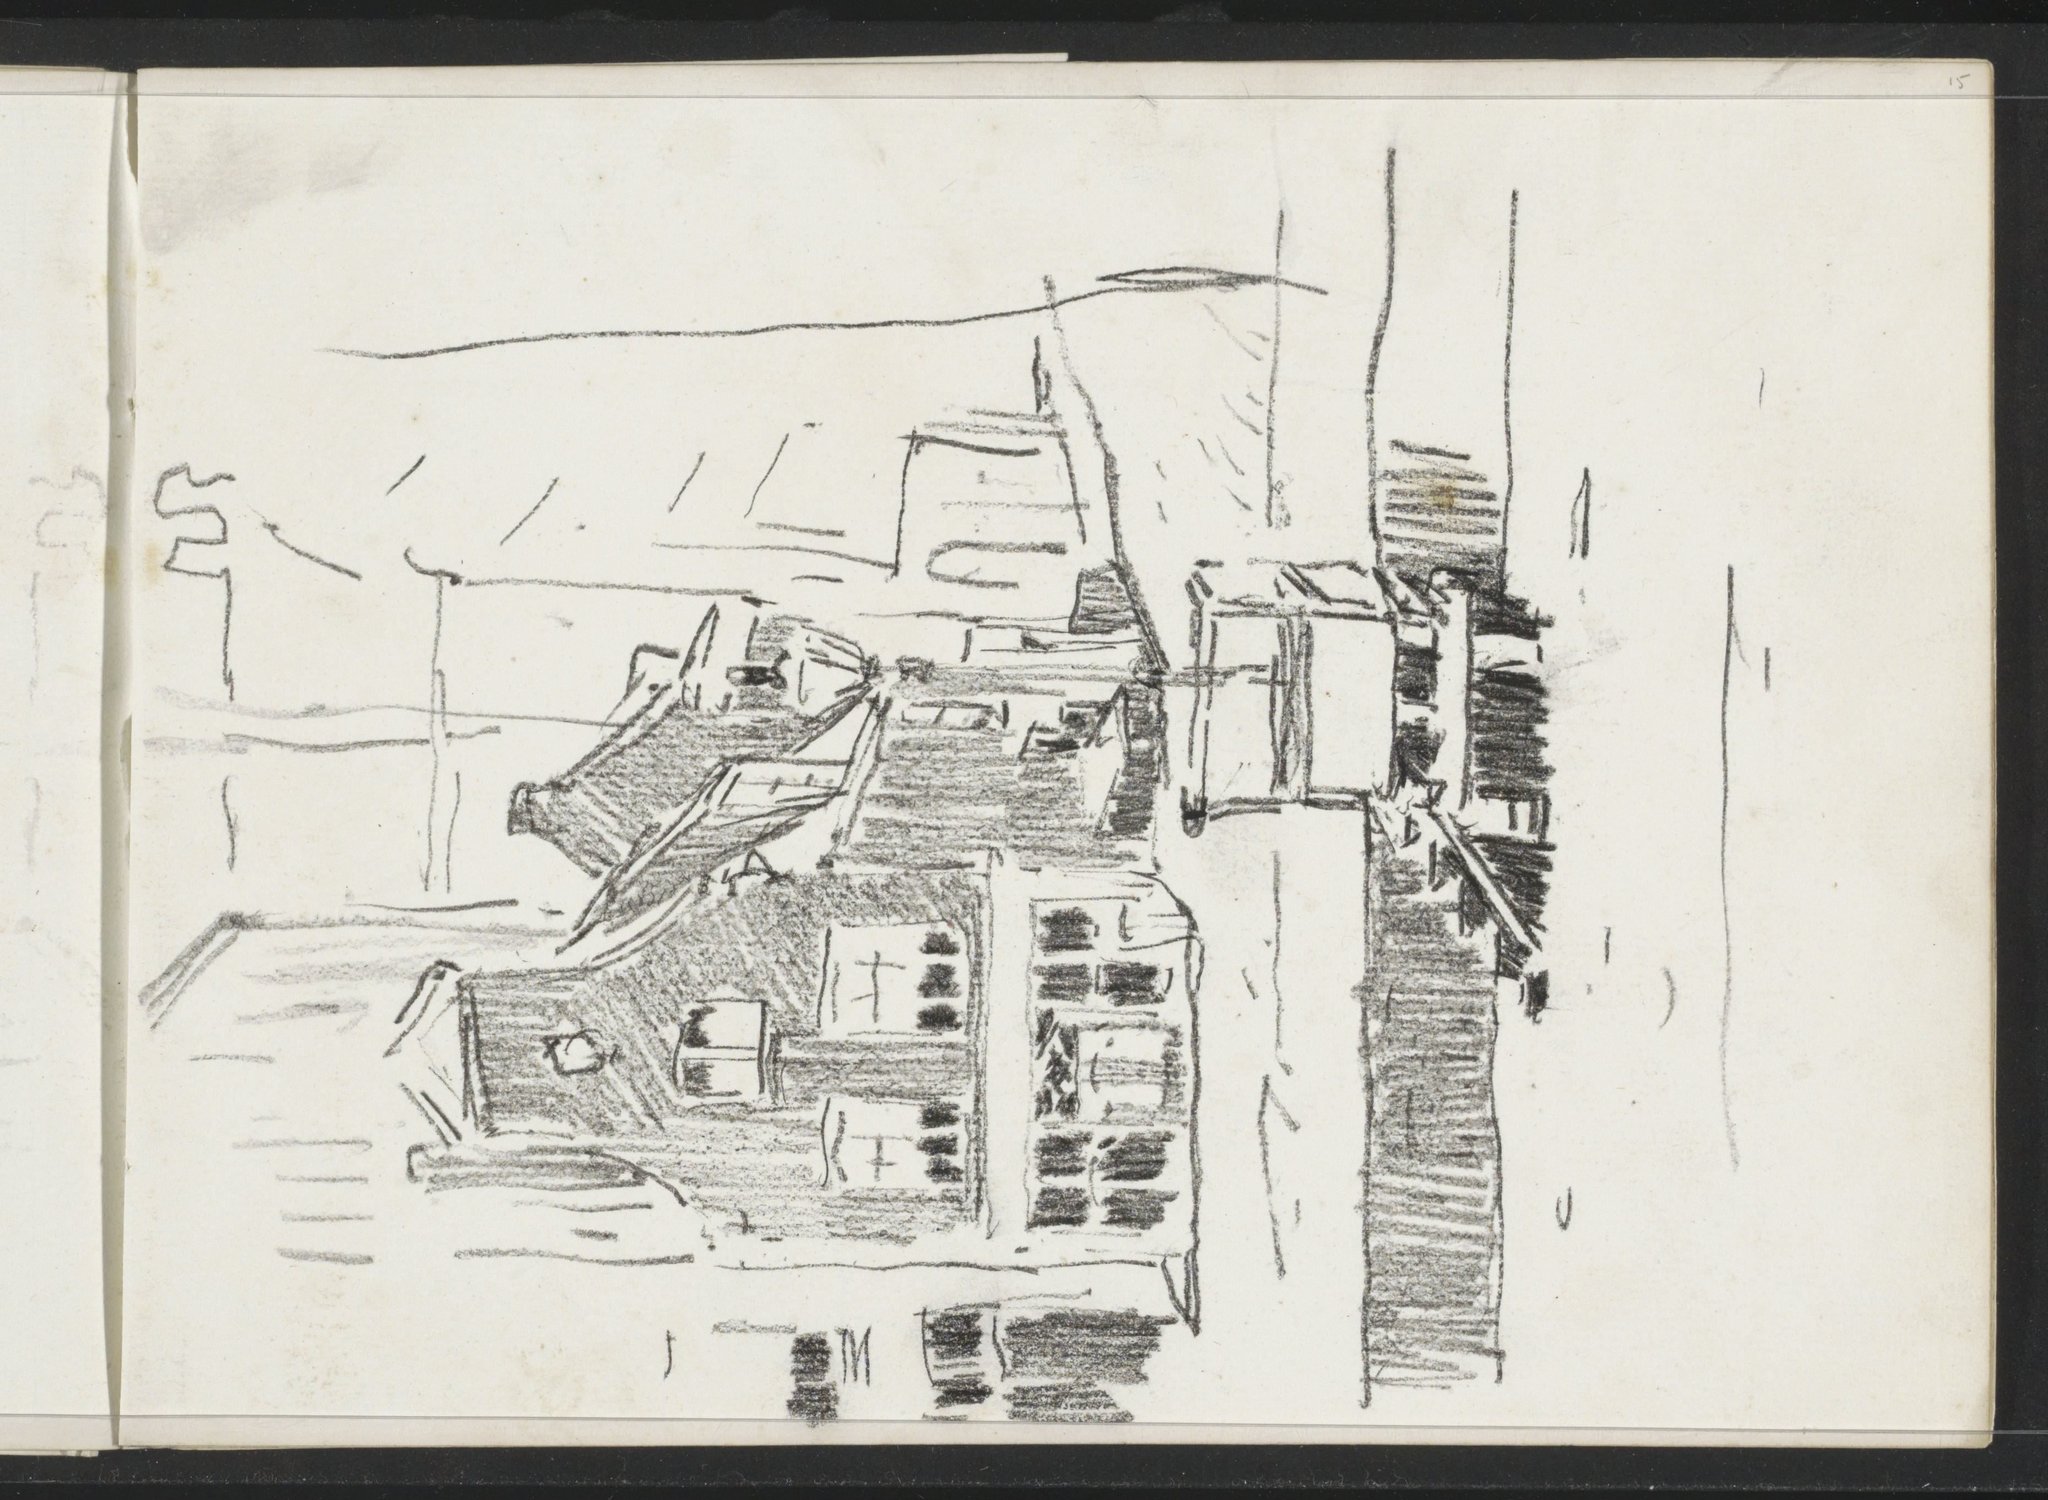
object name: sketchbook leaf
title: Gezicht op de Bierhaven te Rotterdam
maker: willem witsen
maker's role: draughtsman, painter, print maker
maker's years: 1860-1923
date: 1896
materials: chalk, paper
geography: rotterdam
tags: civic architecture; edifices; dwellings, quay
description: Voorstudie voor de ets 'Bierhaven, Rotterdam', 1896.